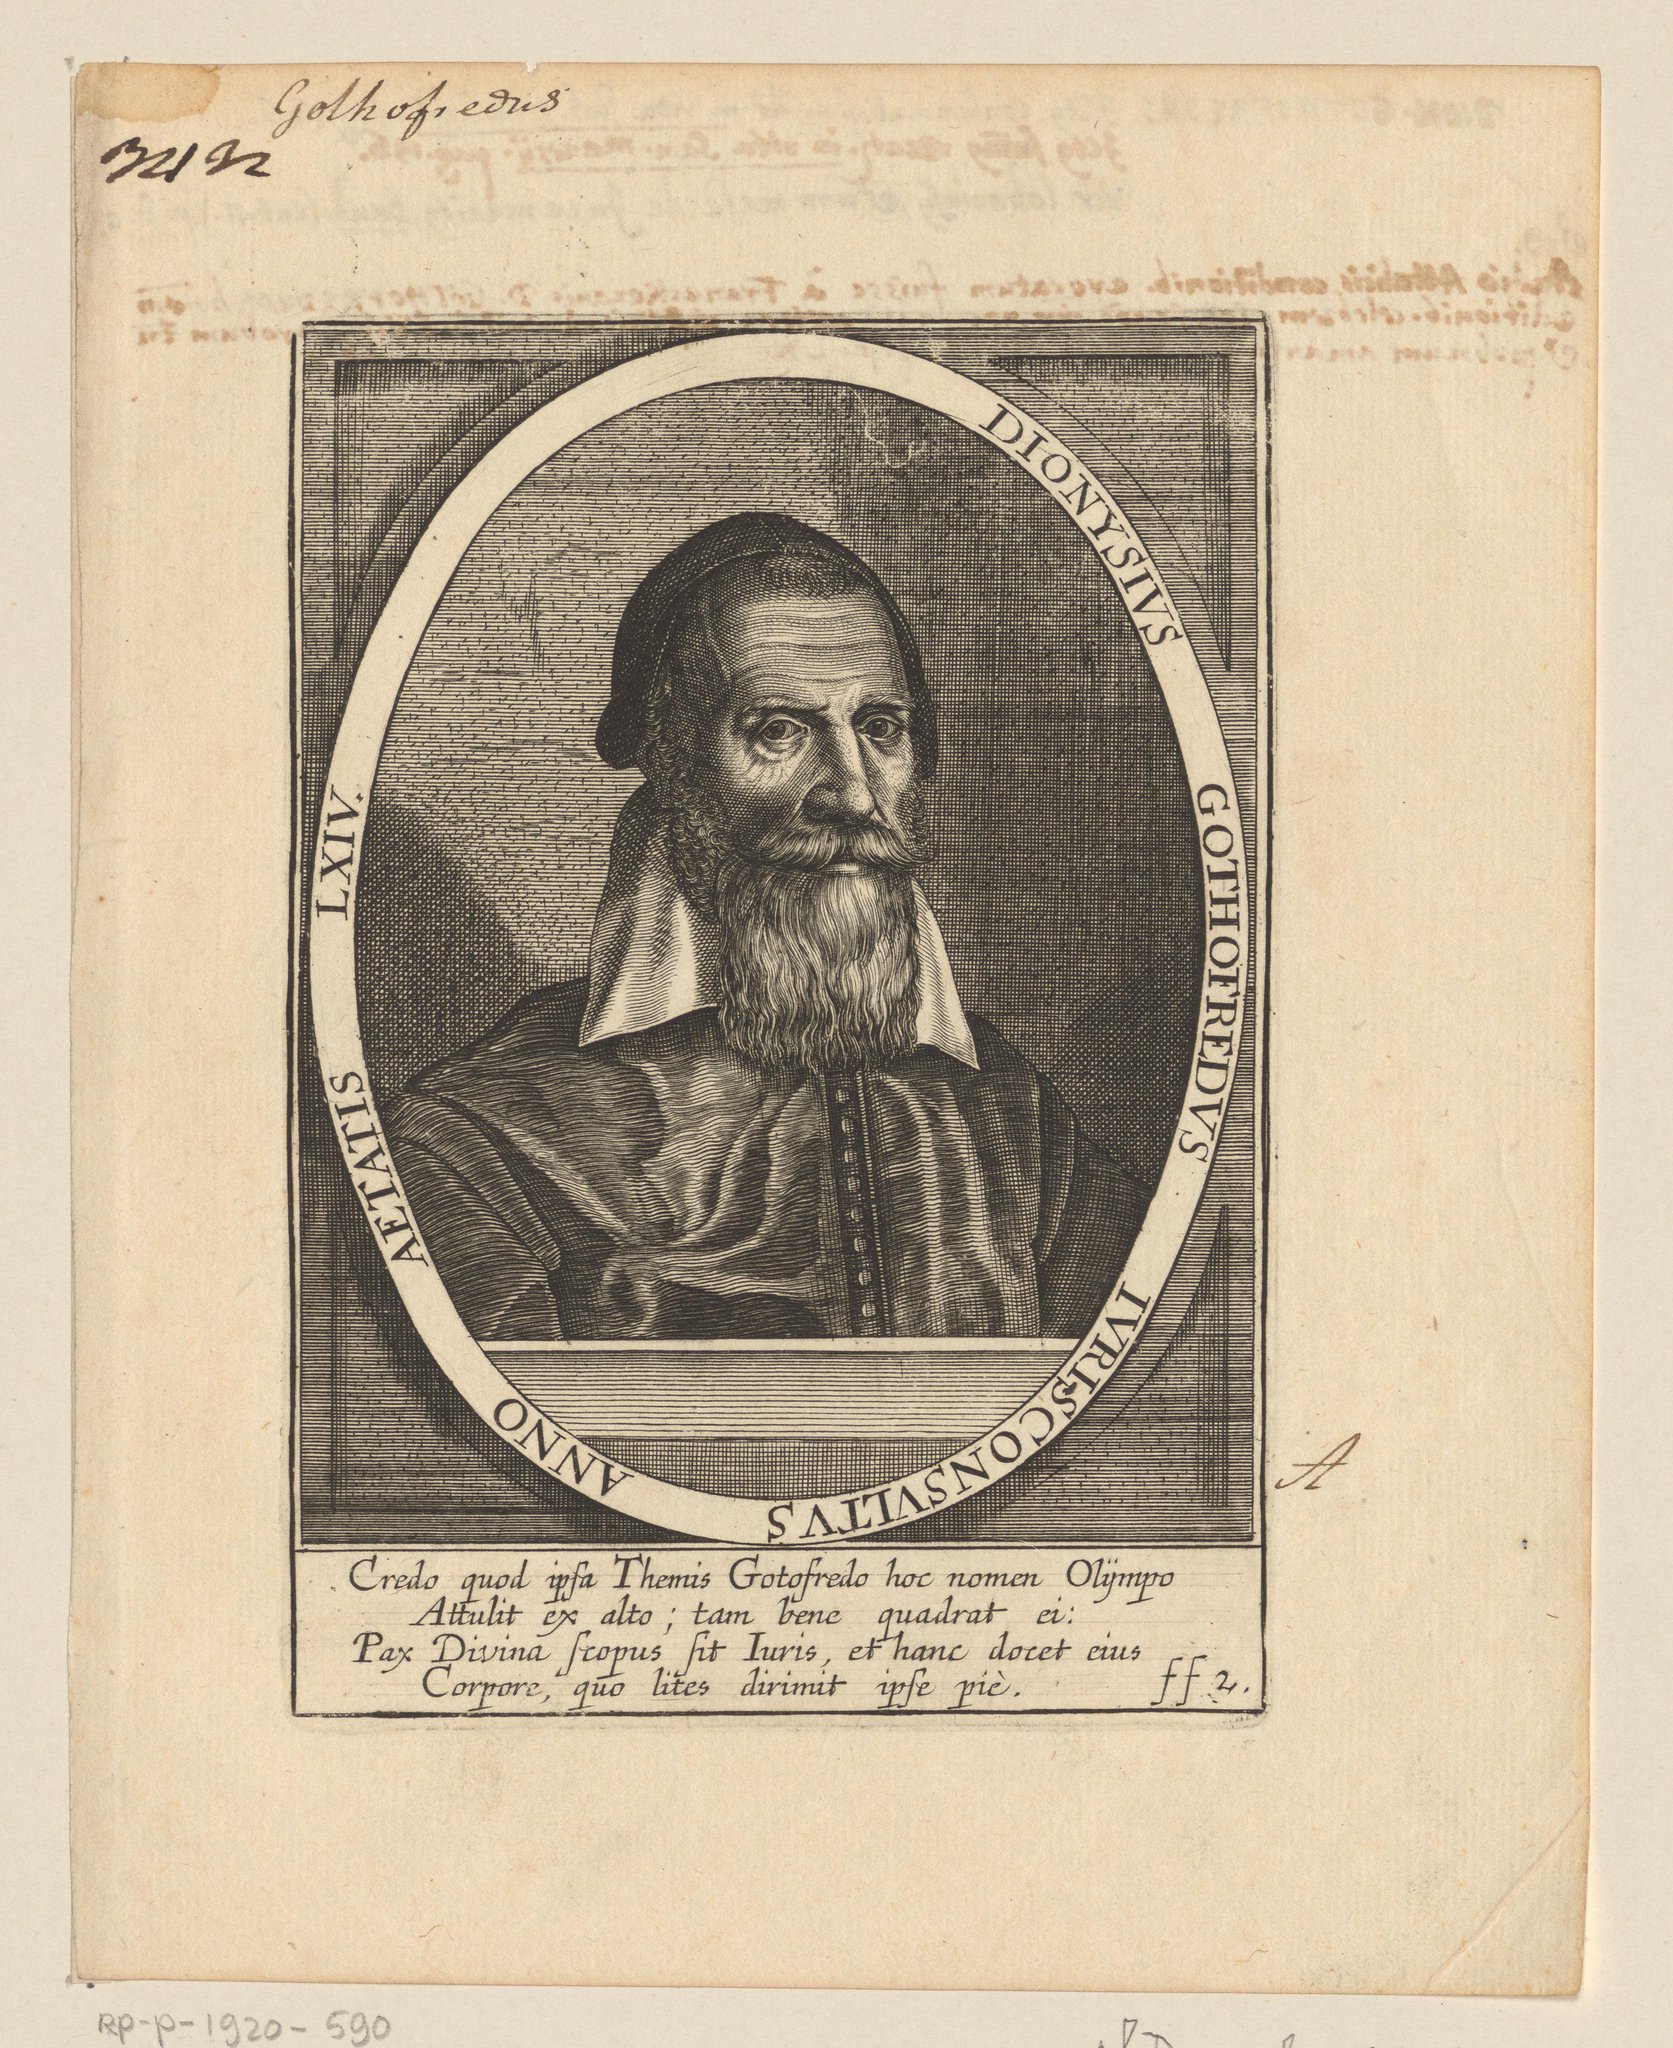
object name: book illustration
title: Portret van Denis Godefroy op 64-jarige leeftijd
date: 1650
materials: paper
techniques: engraving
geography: frankfurt am main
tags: paris, historical persons, professor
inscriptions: collector's mark: Lugt 2228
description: Prent uit: Bibliotheca chalcographica. Frankfurt am Main: Johannes Ammon, 1650